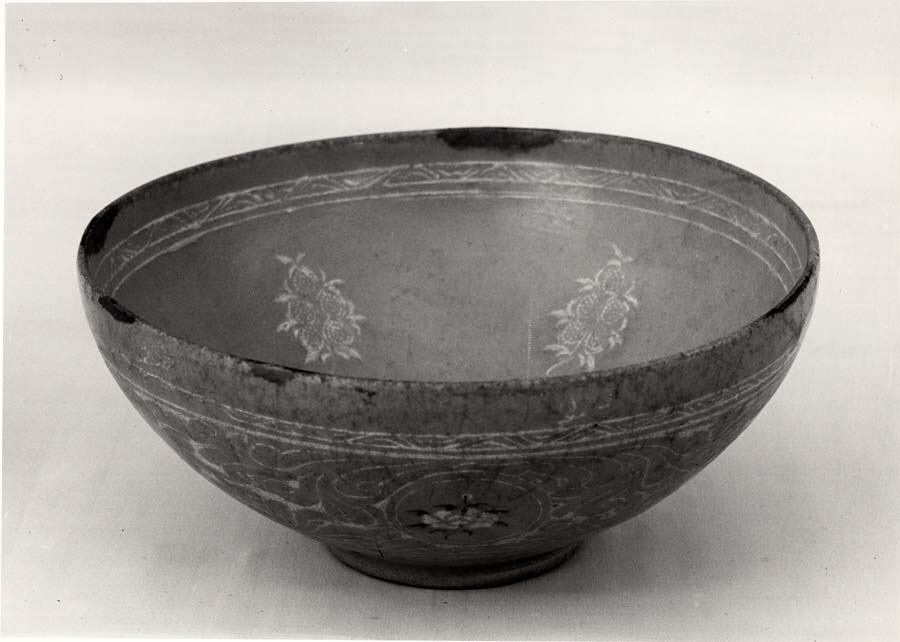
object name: bowl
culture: korean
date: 1201-1300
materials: ceramic glaze, glaze, stoneware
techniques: inlay